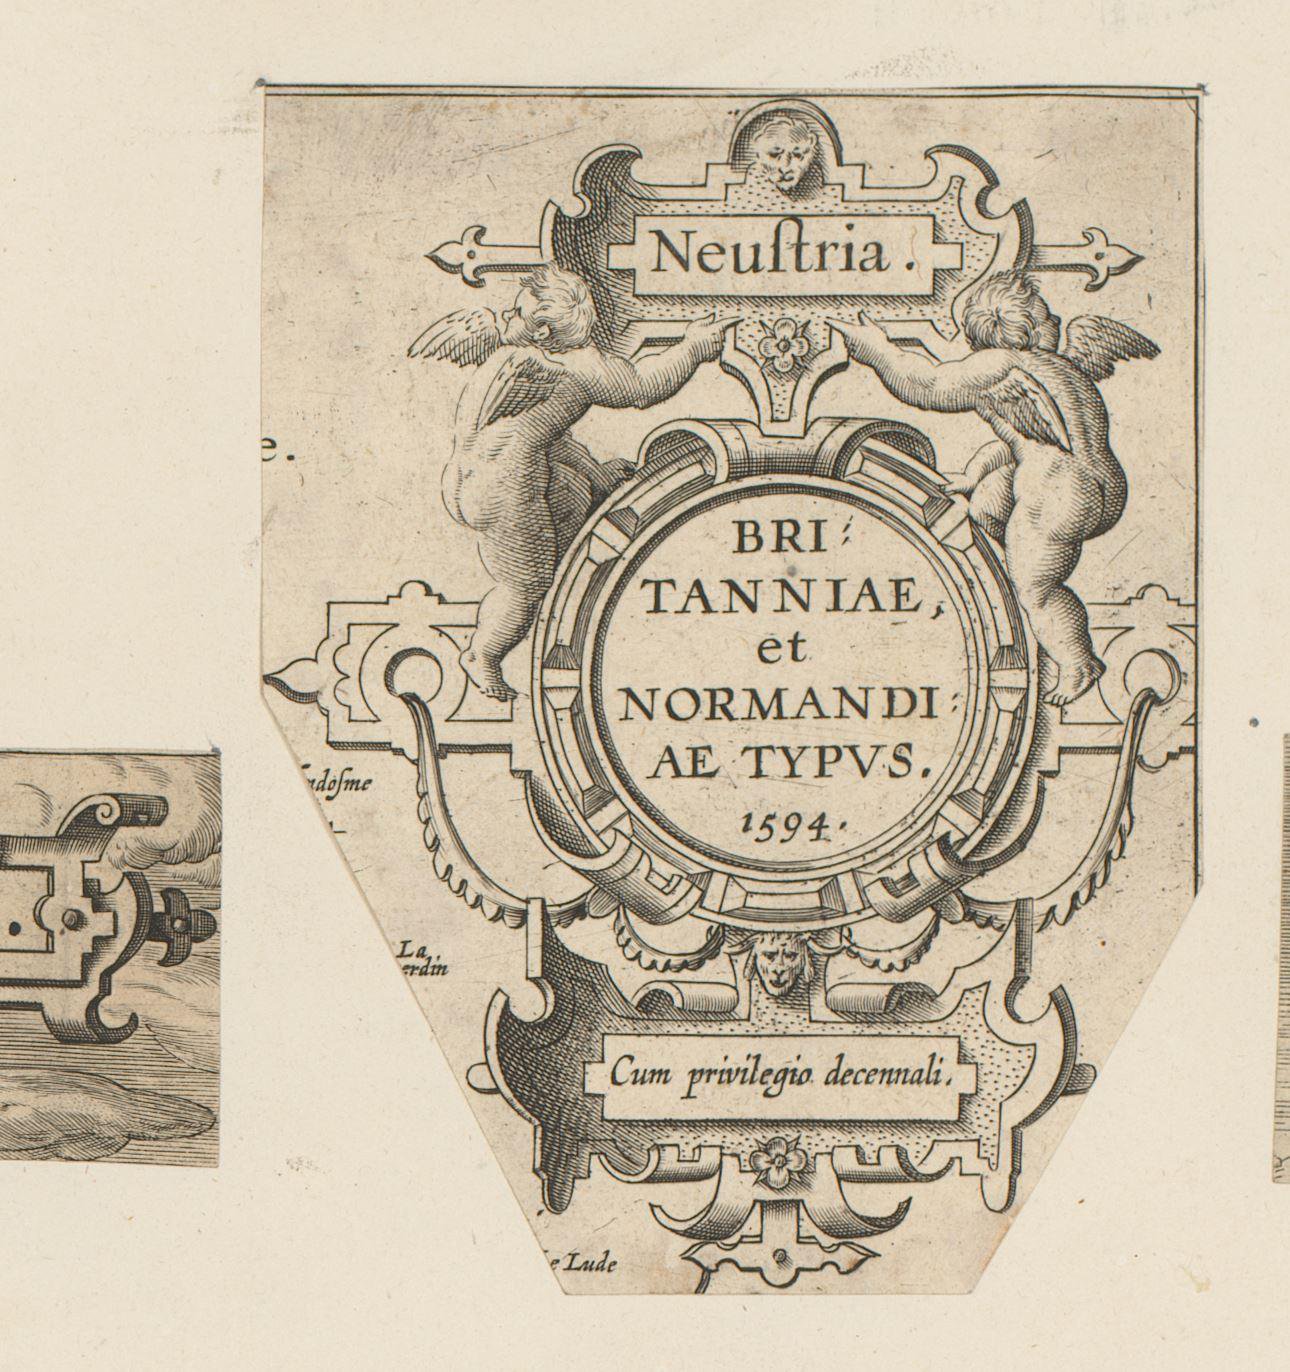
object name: album leaf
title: Neustria. Britanniae et Normandiae Typus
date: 1595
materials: paper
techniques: engraving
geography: antwerp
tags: scrollwork, strapwork ~ ornament, ornament ~ cartouche, cupids: 'amores', 'amoretti', 'putti'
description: Ronde cartouche met twee putti die wijzen naar de tekst Neustria. De cartouche is een fragment van een kaart van Normandië en Bretagne. De prent maakt deel uit van een album.